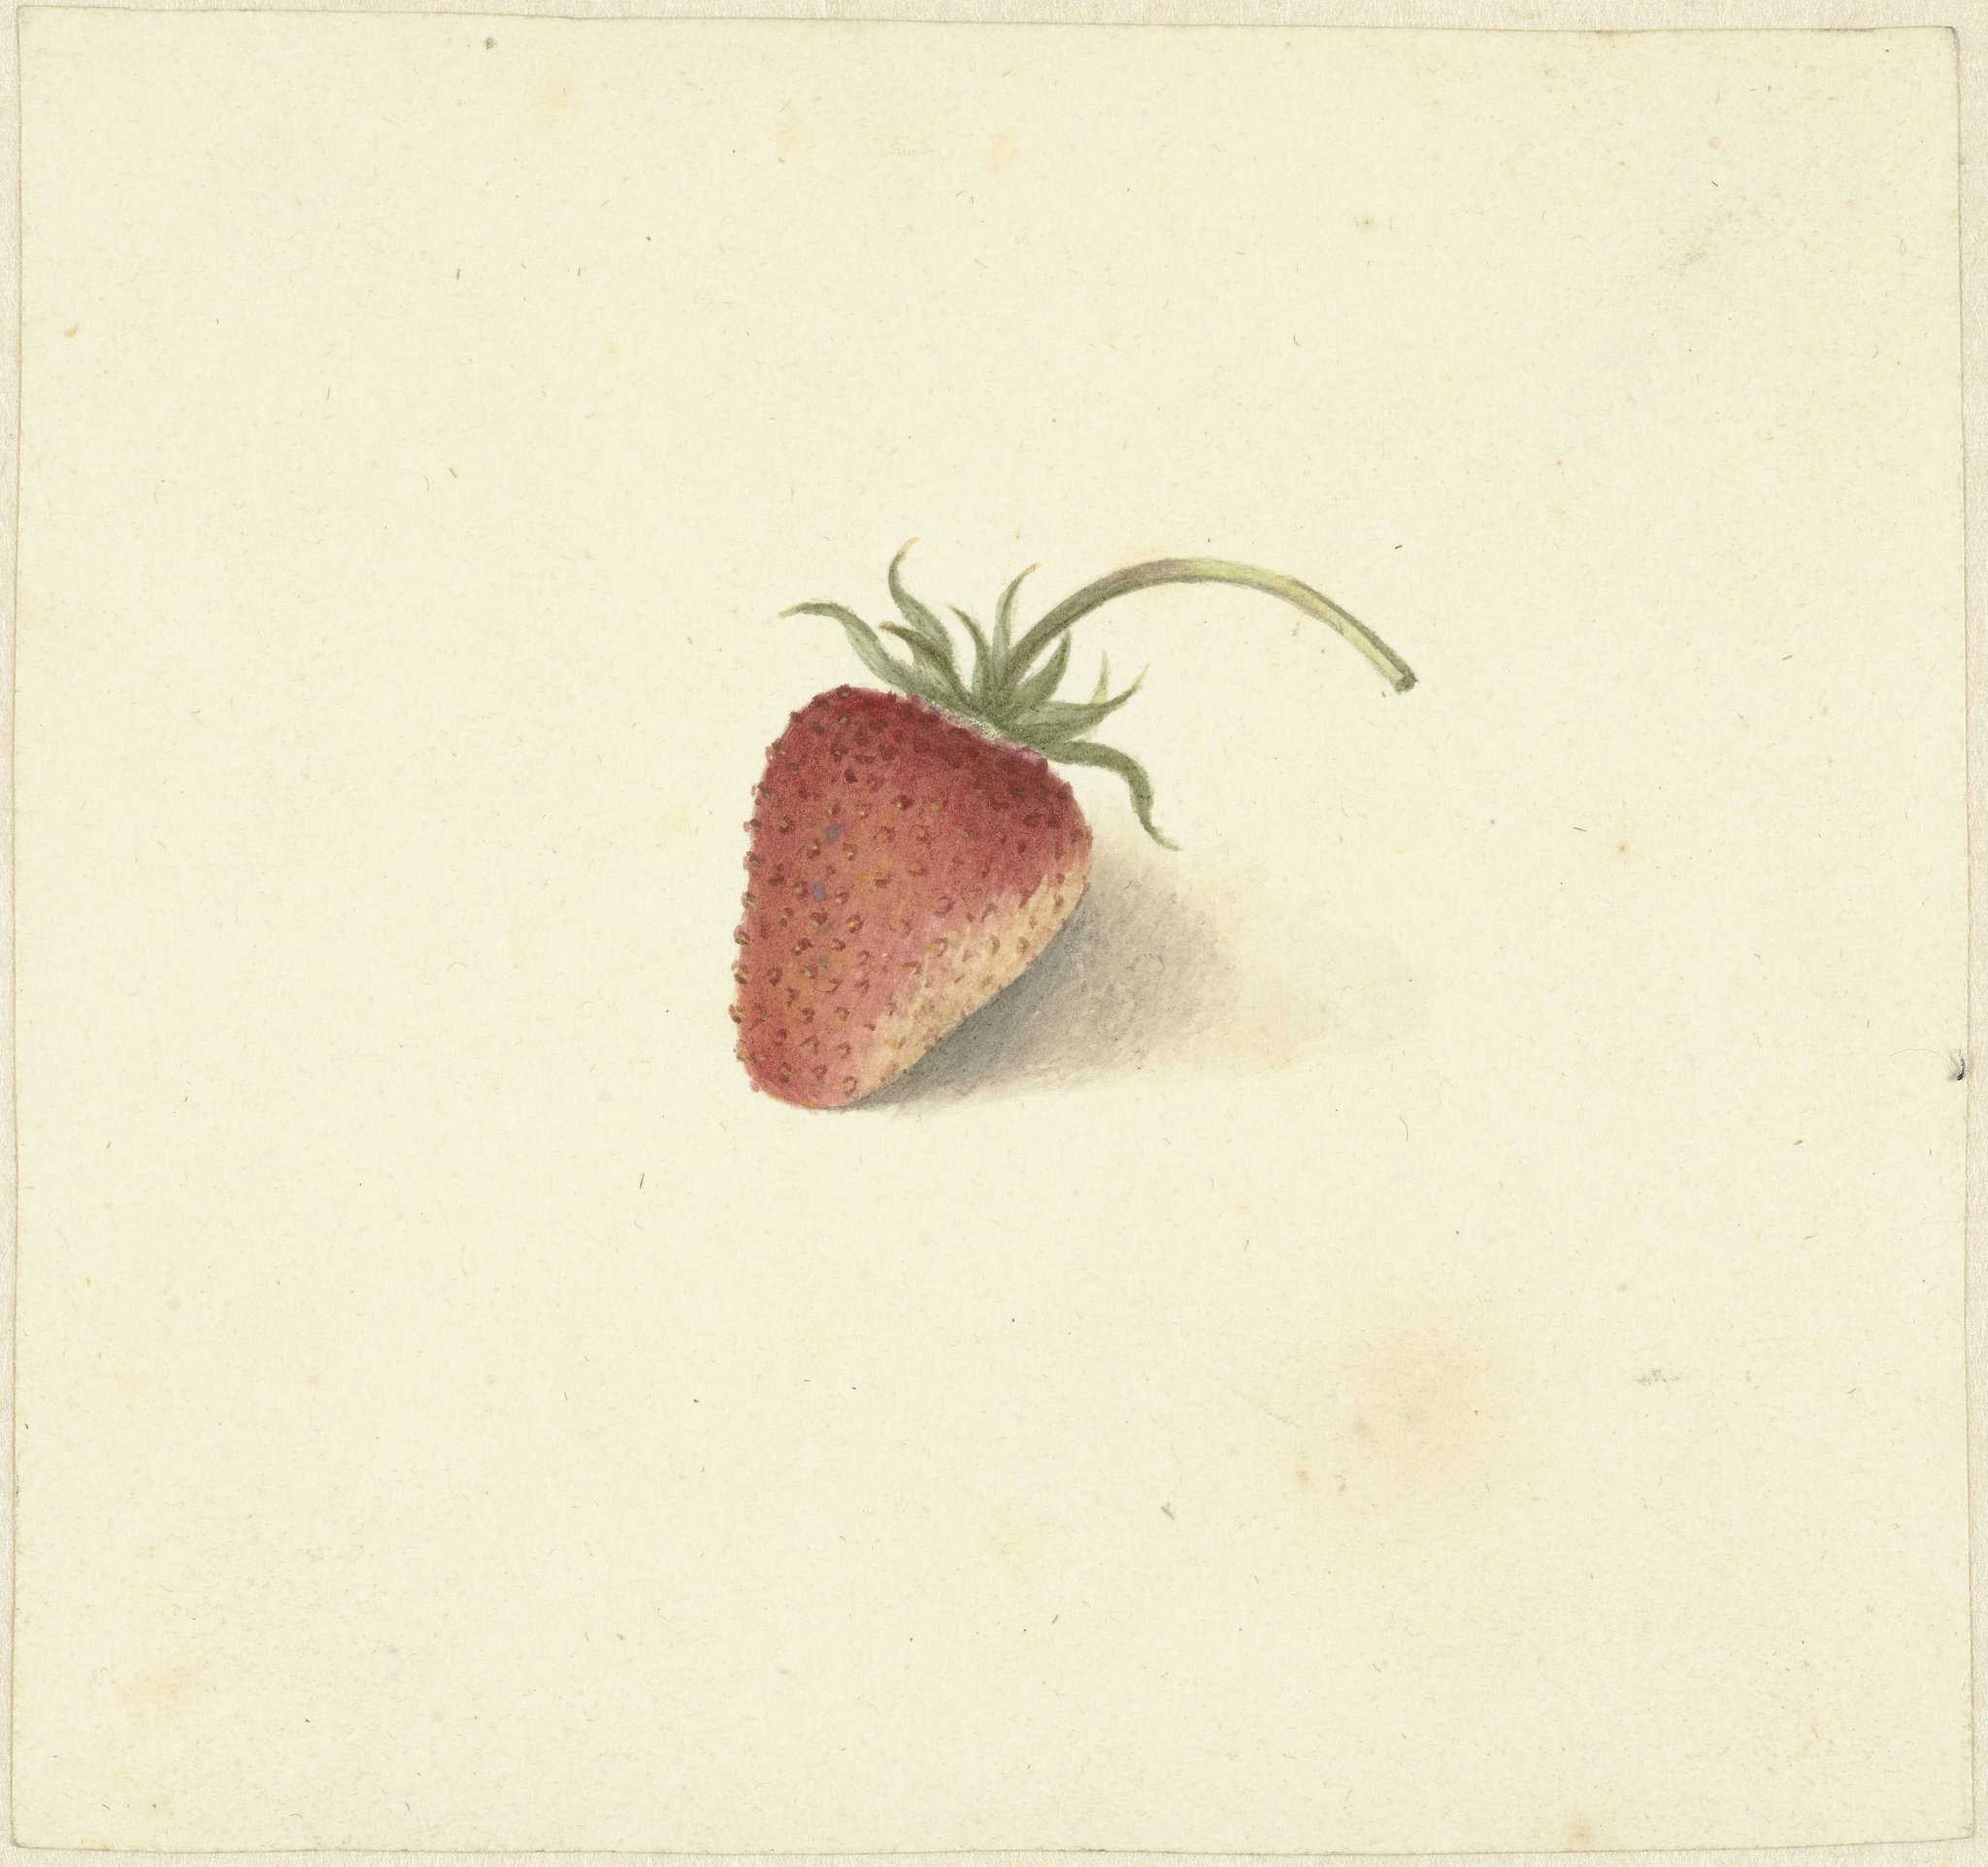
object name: watercolor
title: Aardbei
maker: elisabeth geertruida van de kasteele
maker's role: draughtsman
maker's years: 1808-1853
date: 1818-1853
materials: paper, watercolor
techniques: brush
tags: fruits: strawberry